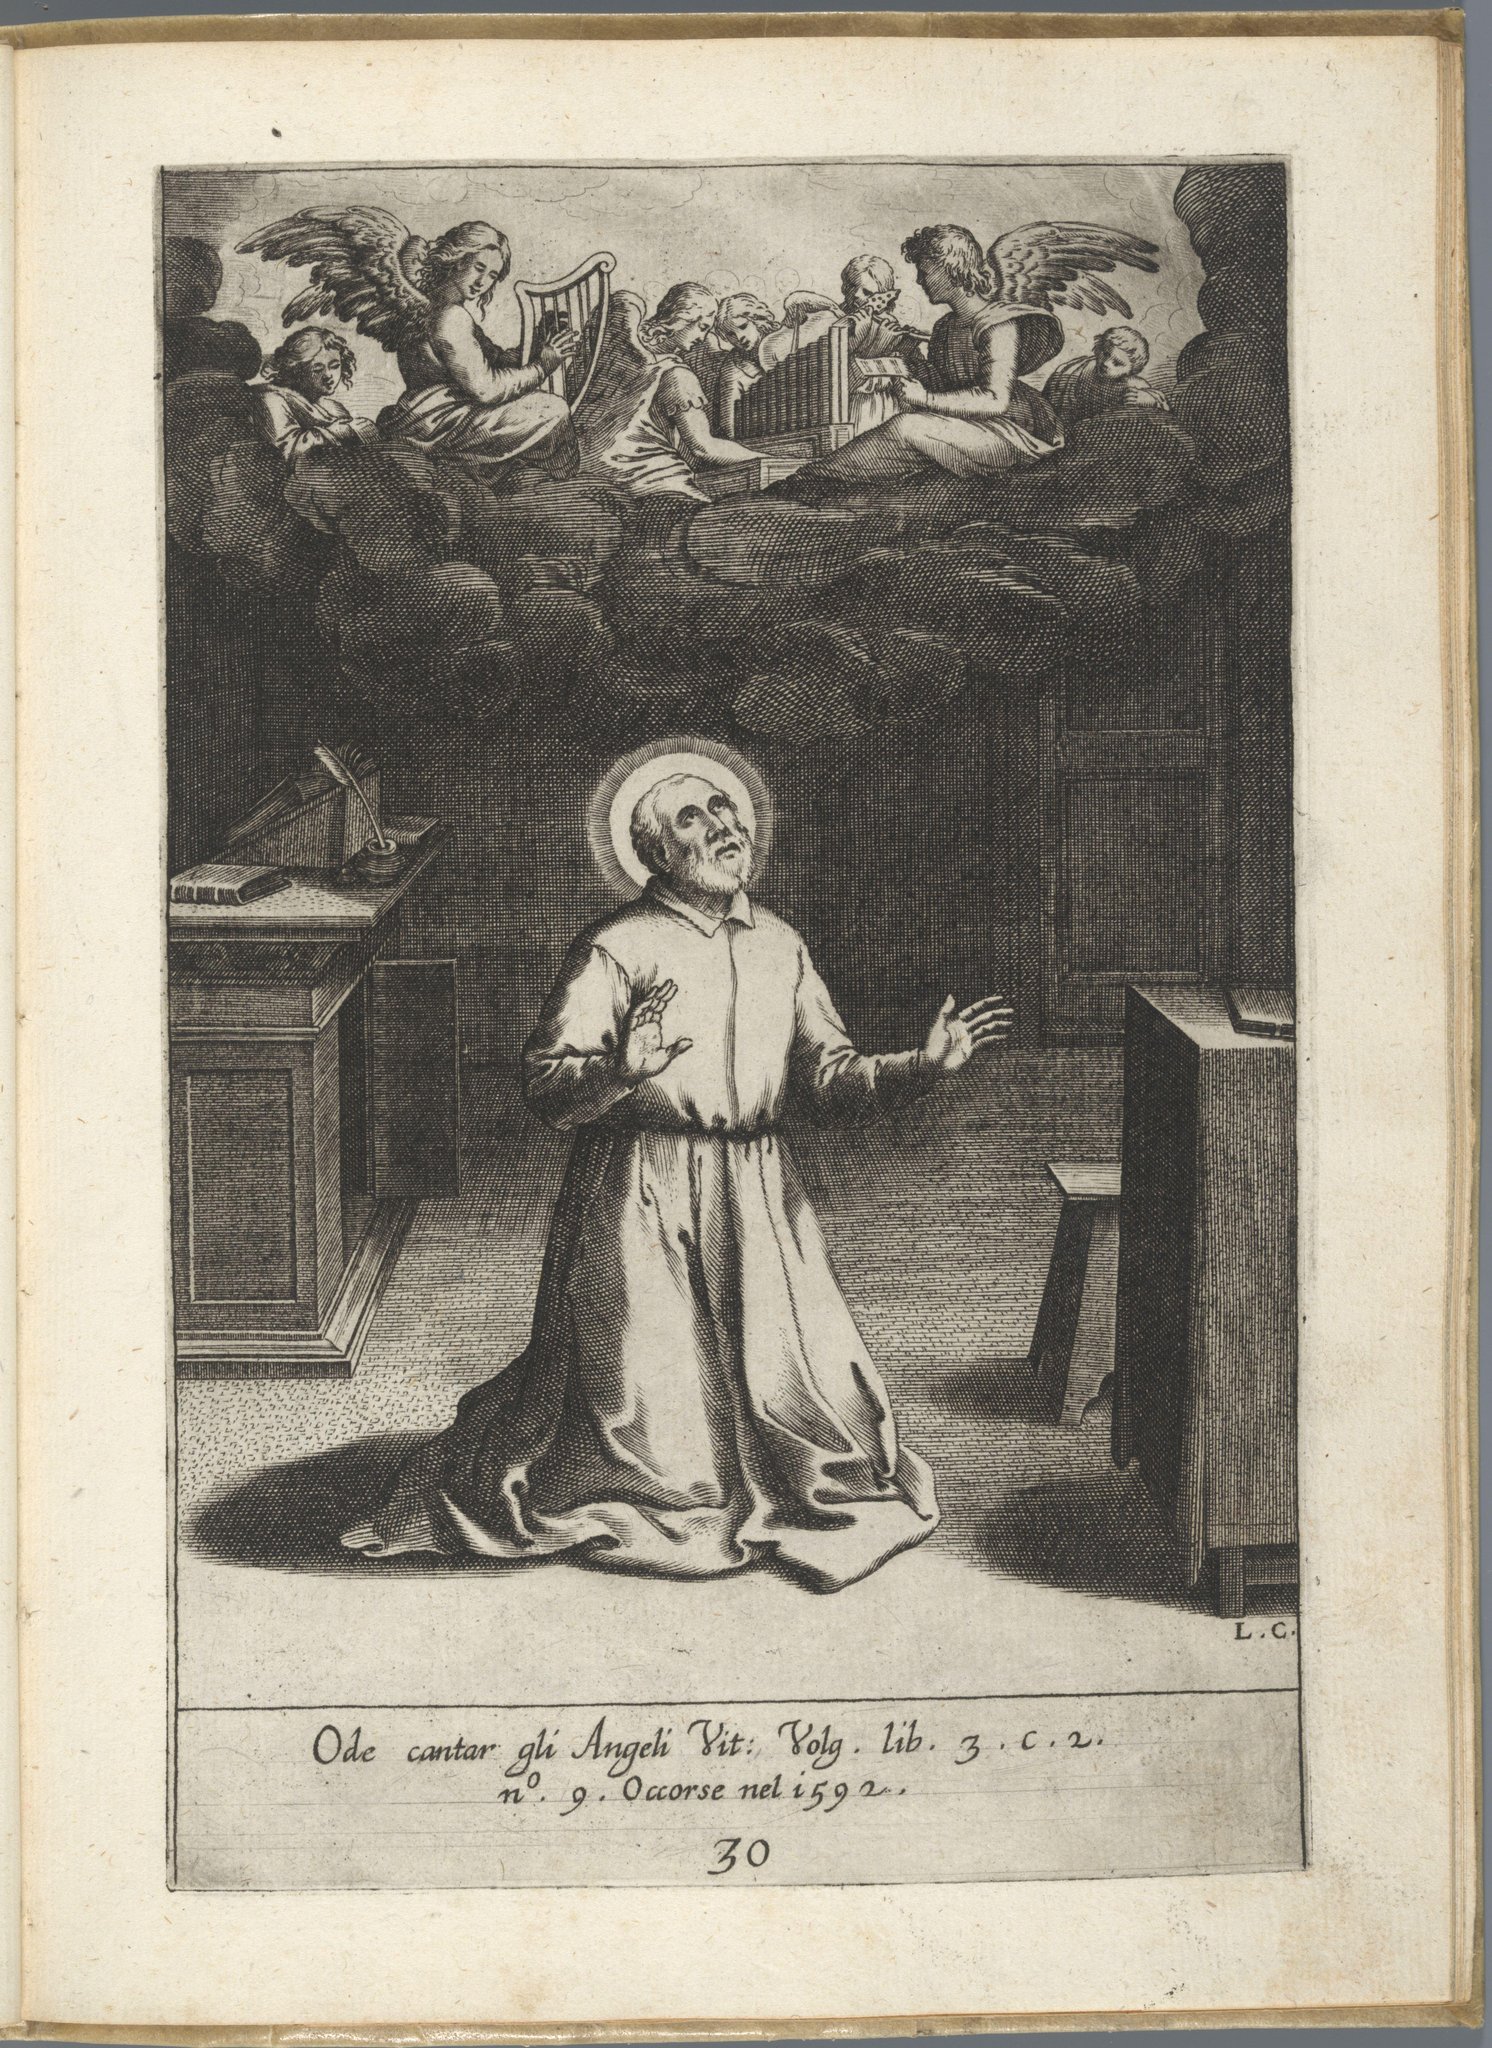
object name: print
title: Filippo Neri hoort de engelen zingen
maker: luca ciamberlano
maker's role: painter, print maker, publisher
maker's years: 1570-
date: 1630-1641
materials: paper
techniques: engraving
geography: rome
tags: rome, clergyman, the founder of the congregation of the oratory (oratorians) philip neri; possible attributes: lily, rosary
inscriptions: collector's mark: Lugt 2760, collector's mark: Lugt 2228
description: Filippo Neri hoort de engelen zingen (1592). Prent nr. 30 in een serie van 44 prenten met scènes uit het leven van de heilige Filippo Neri.